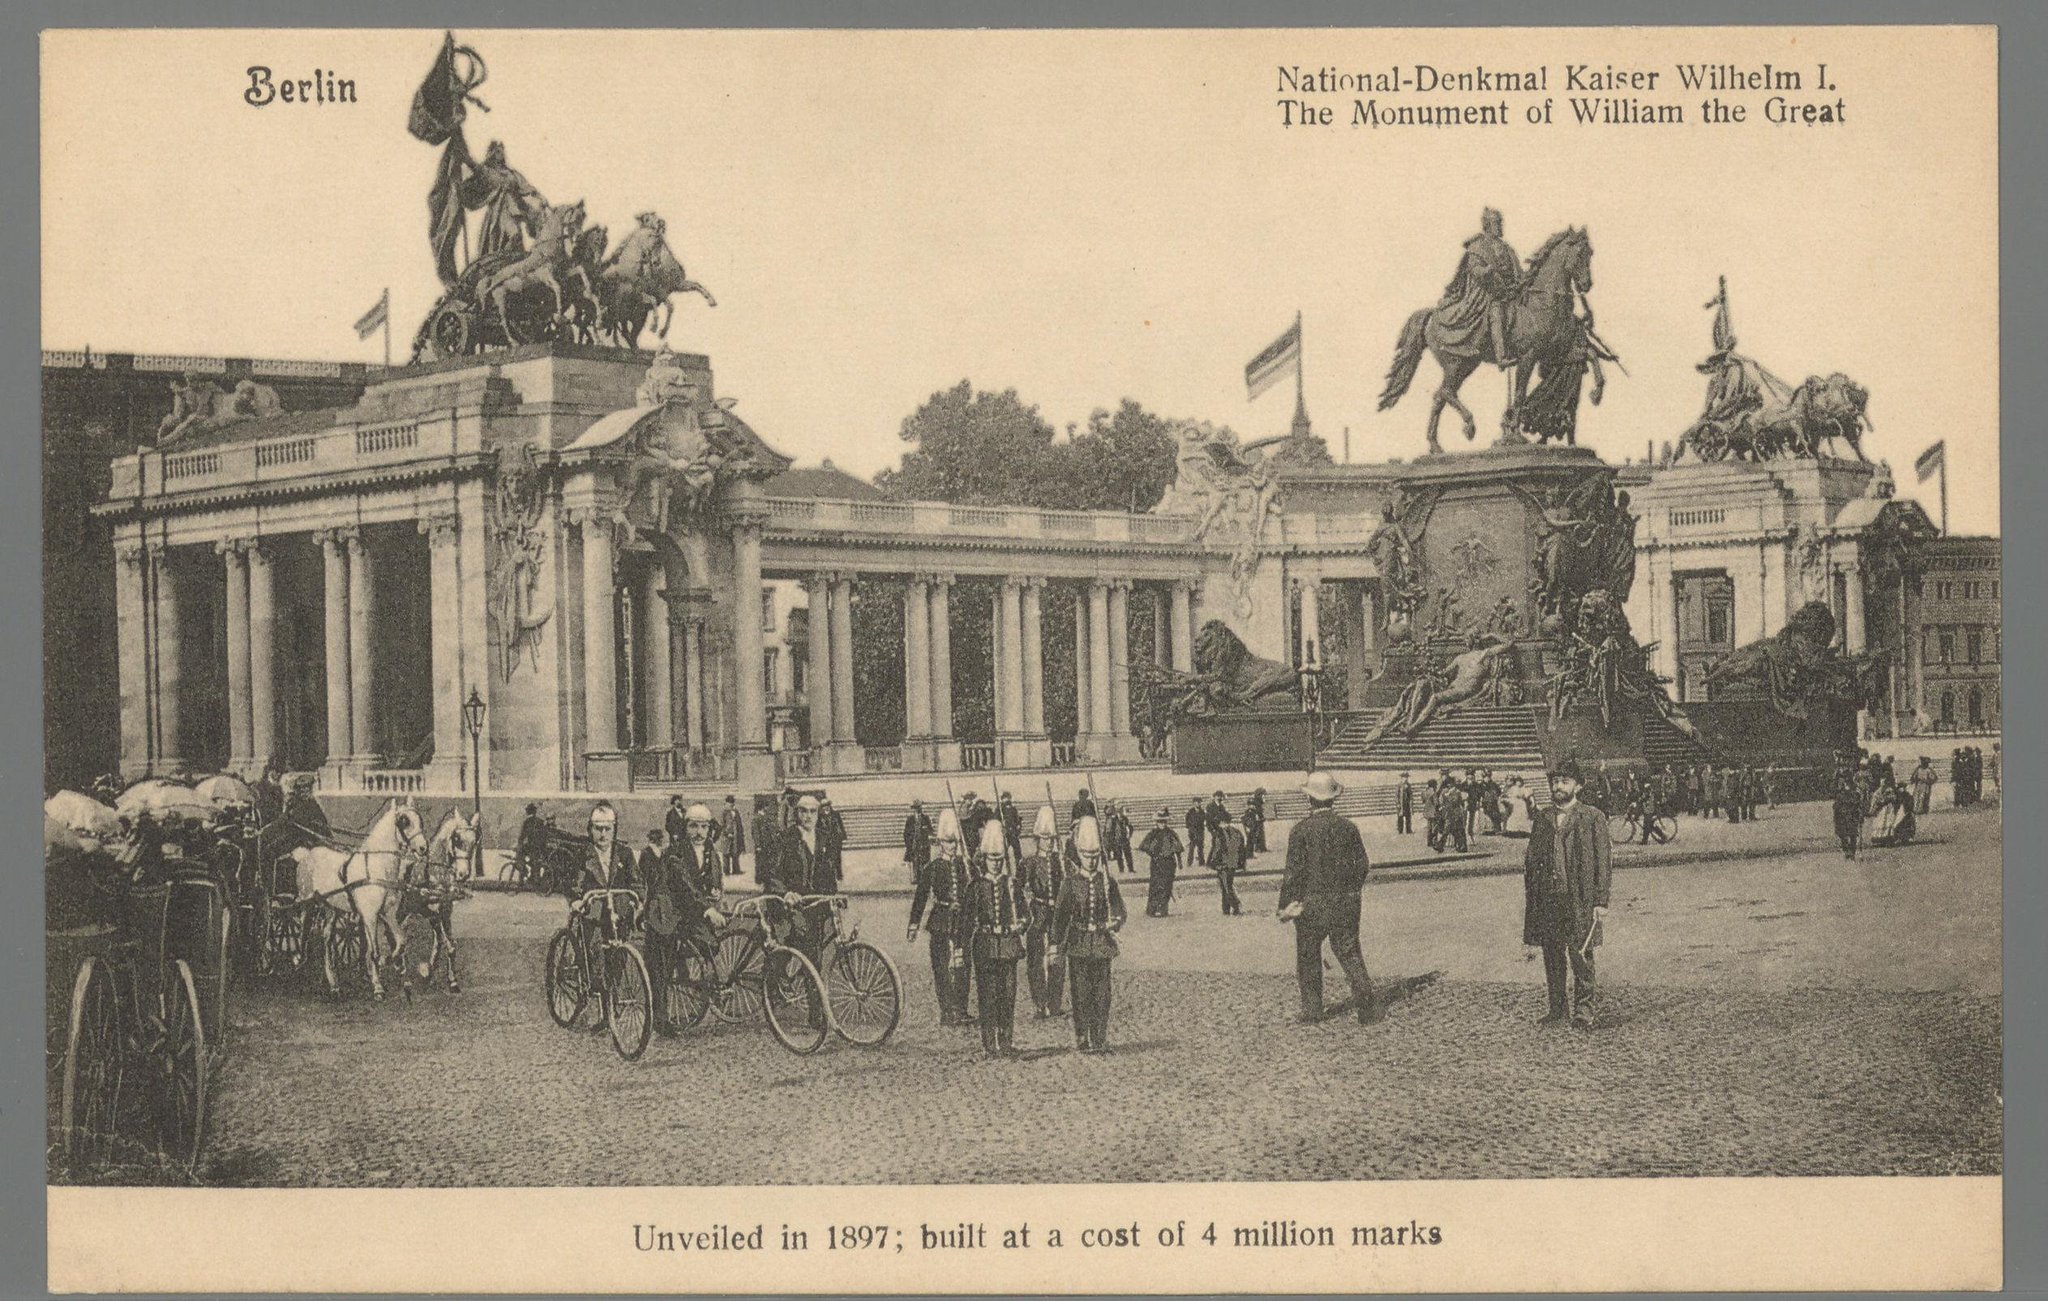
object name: ansichtkaart, prentbriefkaart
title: Berlin. National-Denkmal Kaiser Wilhelm I. / The Monument of William the Great. Unveiled in 1897; built at a cost of 4 million marks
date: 1905-1930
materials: cardboard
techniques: photograph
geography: berlin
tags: berlin, wilhelm i (keizer van duitsland), monument, statue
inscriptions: stamp: ‘5’